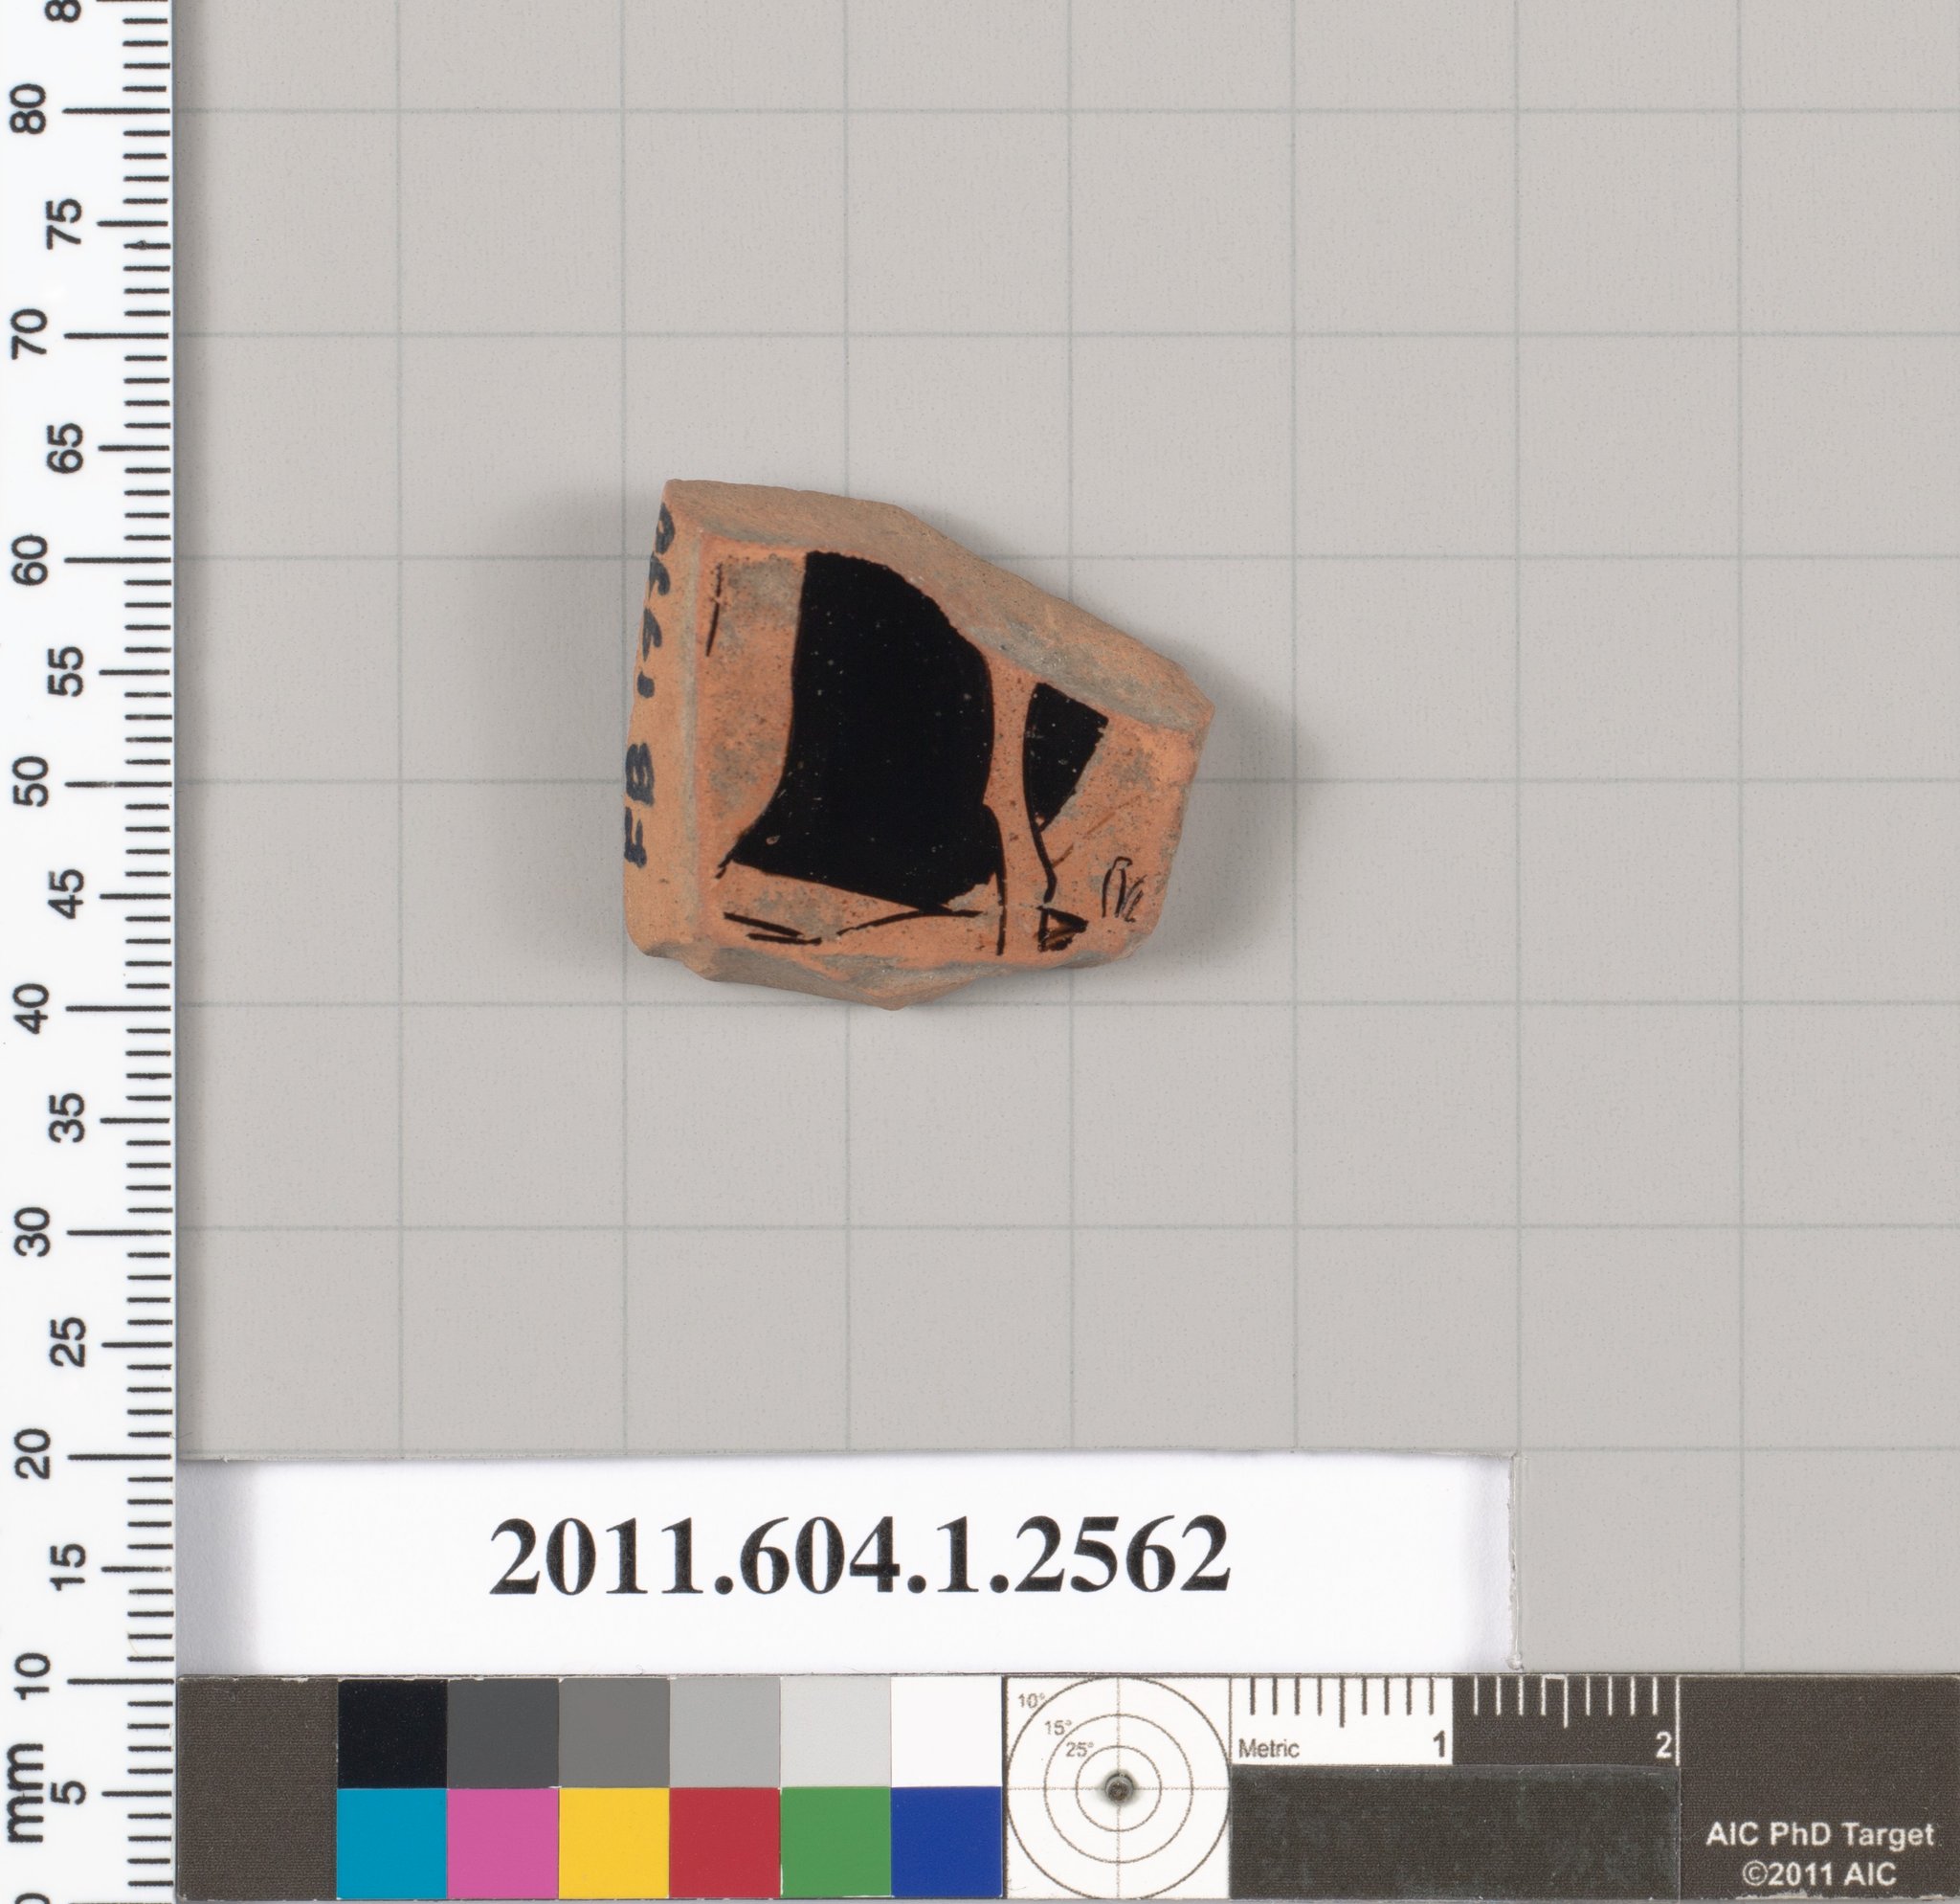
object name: kylix fragment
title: Terracotta fragment of a kylix (drinking cup)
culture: greek, attic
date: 500-451 BCE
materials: terracotta